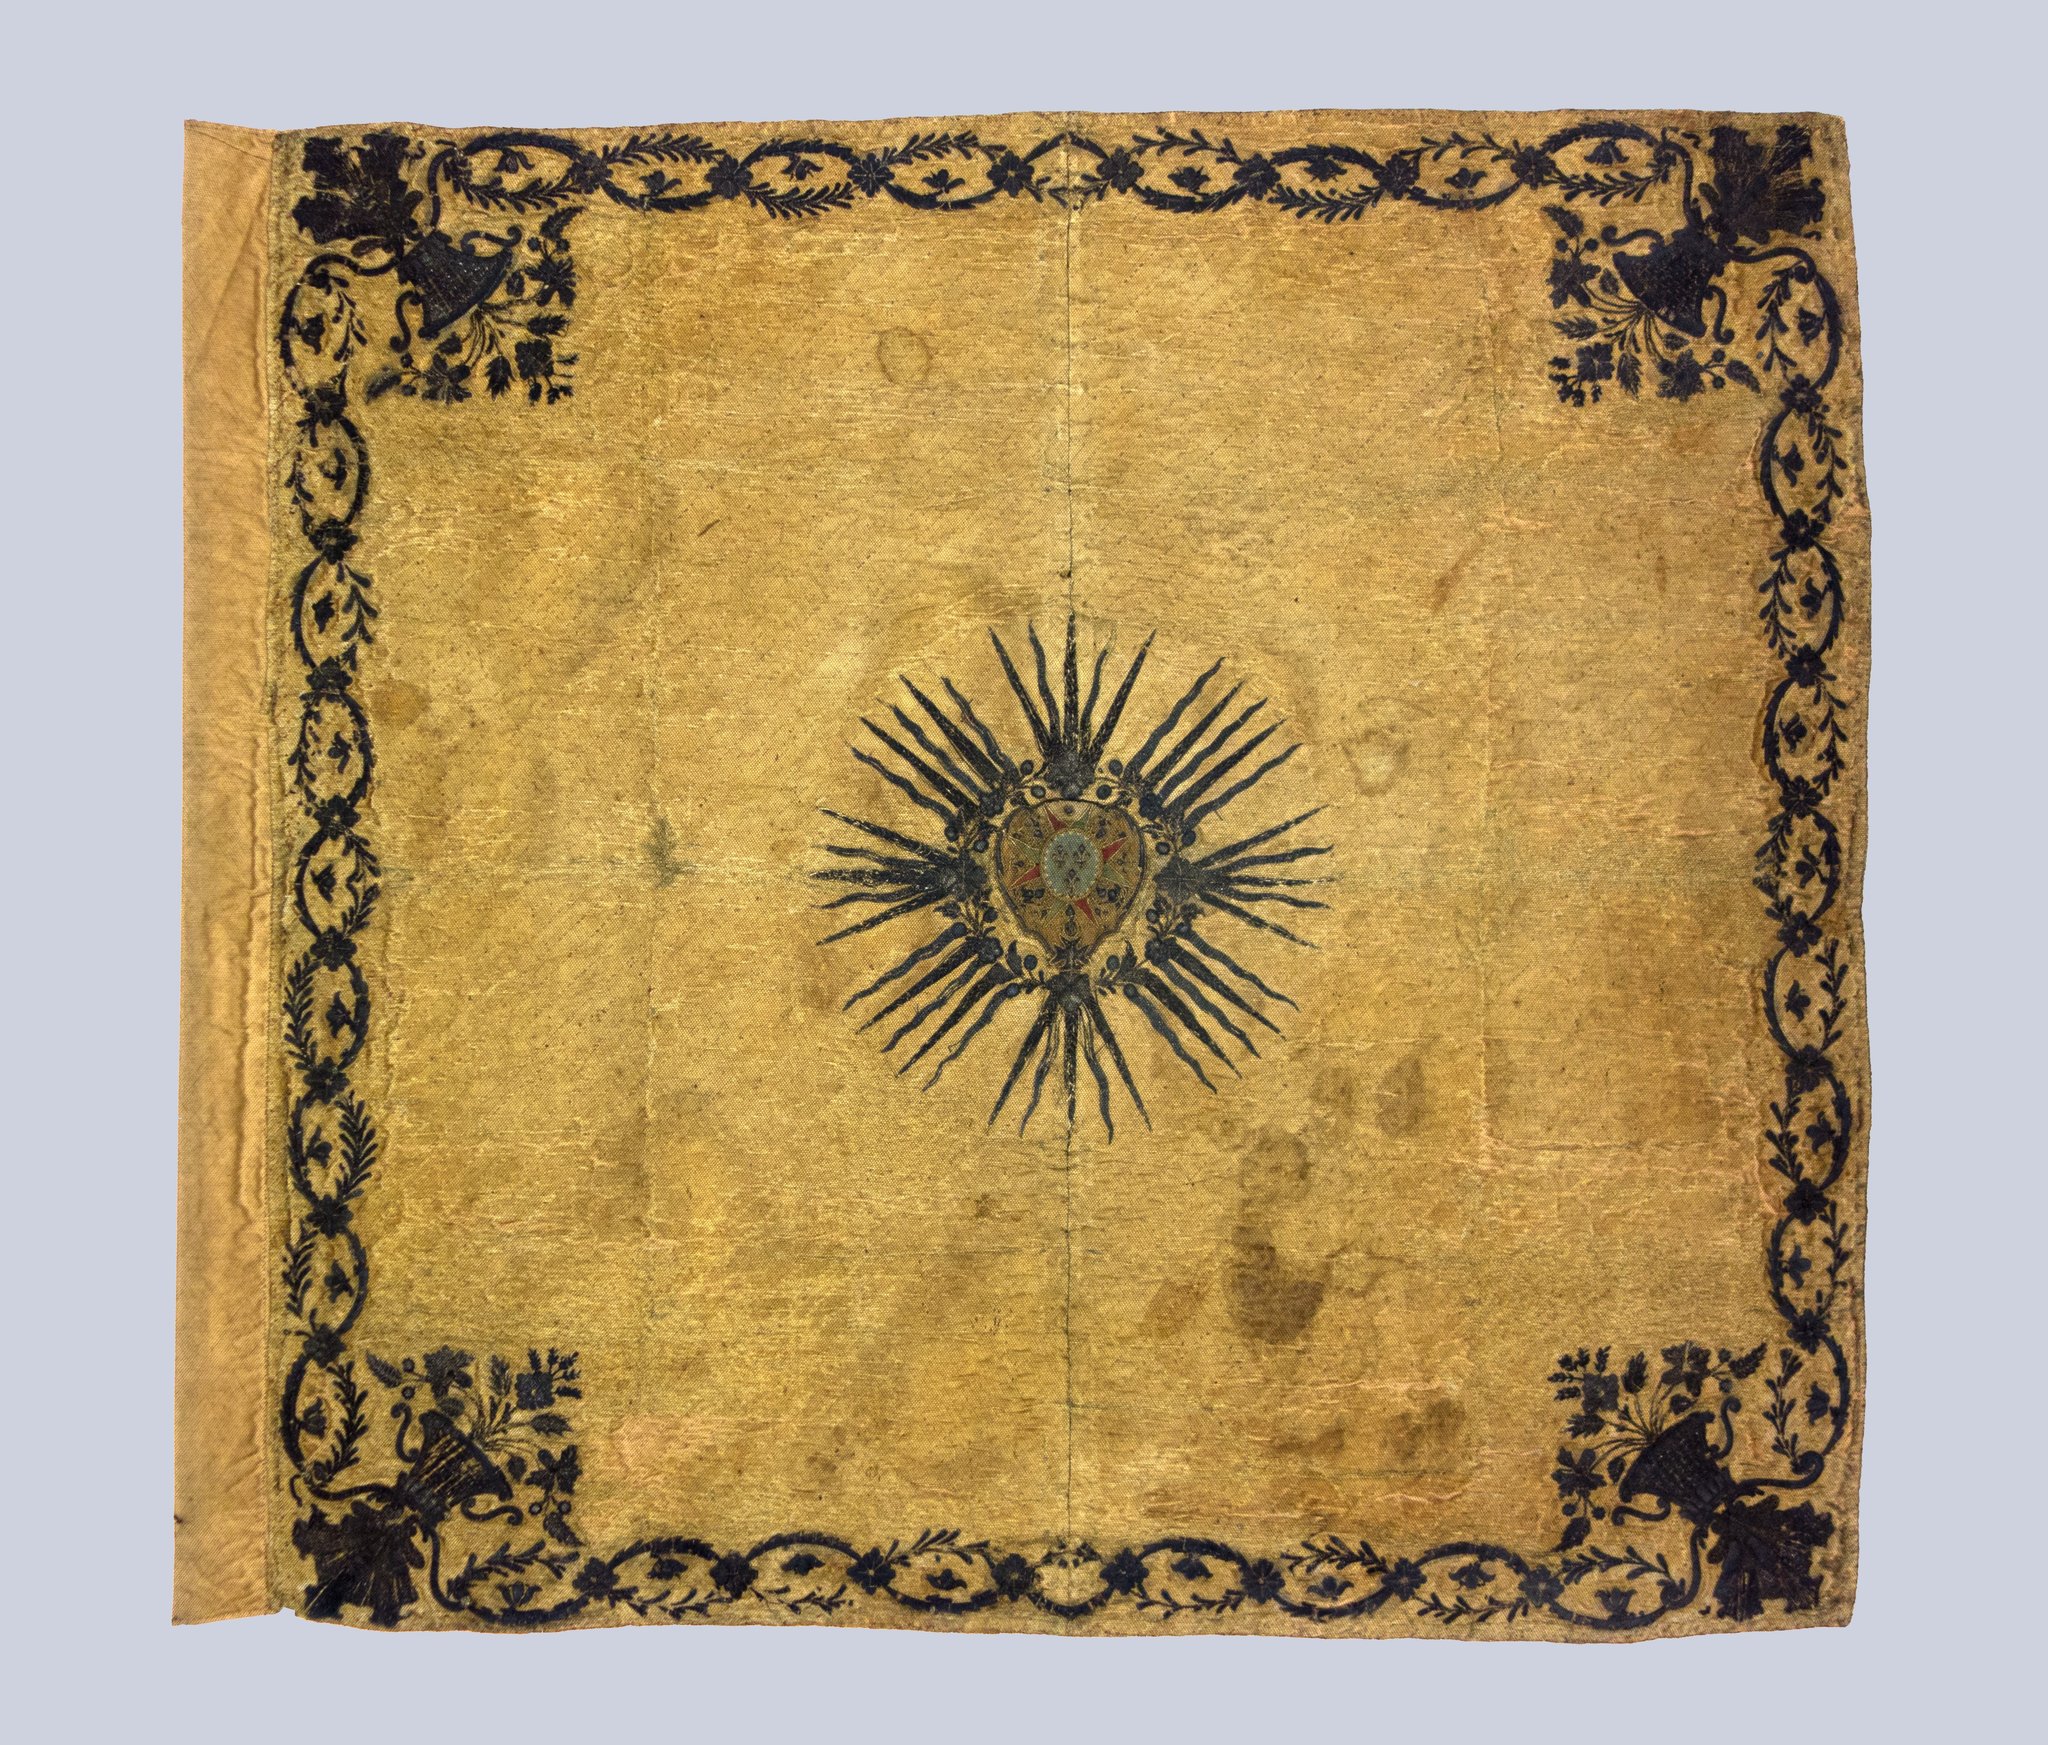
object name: banner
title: Banner of Louis XIV, King of France (r. 1643–1715)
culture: french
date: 1601-1700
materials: metal thread, silk, silver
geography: france